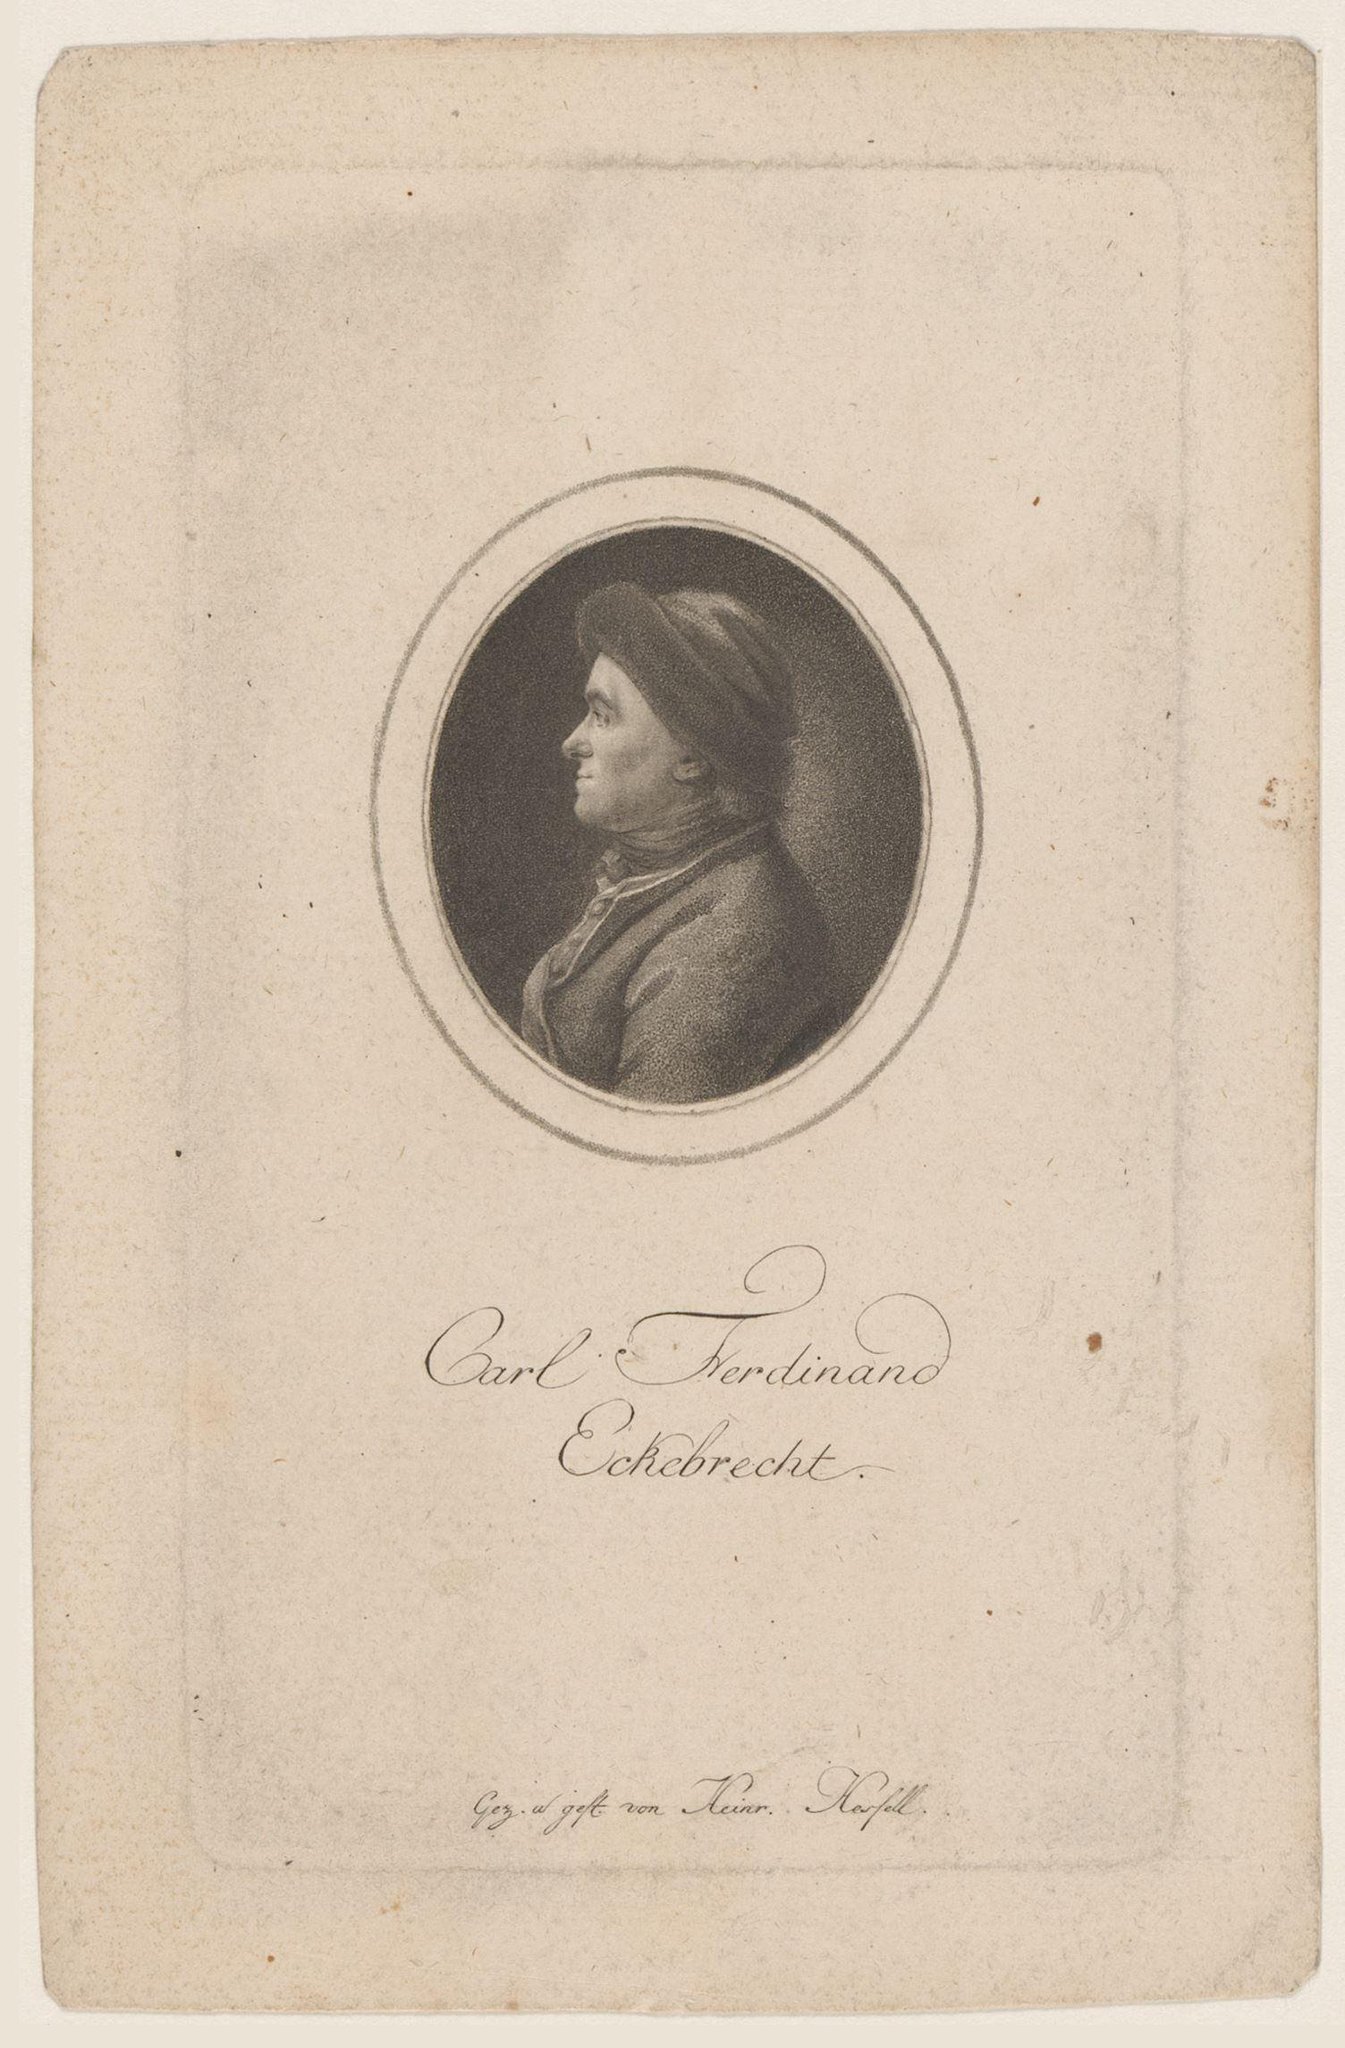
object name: print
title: Portret van Karl Ferdinand Eckebrecht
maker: leonhard heinrich hessell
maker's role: musical instrument maker, painter, print maker, publisher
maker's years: 1757-1830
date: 1767-1830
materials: paper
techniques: aquatint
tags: manufacturer, historical persons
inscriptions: collector's mark: Lugt 2228